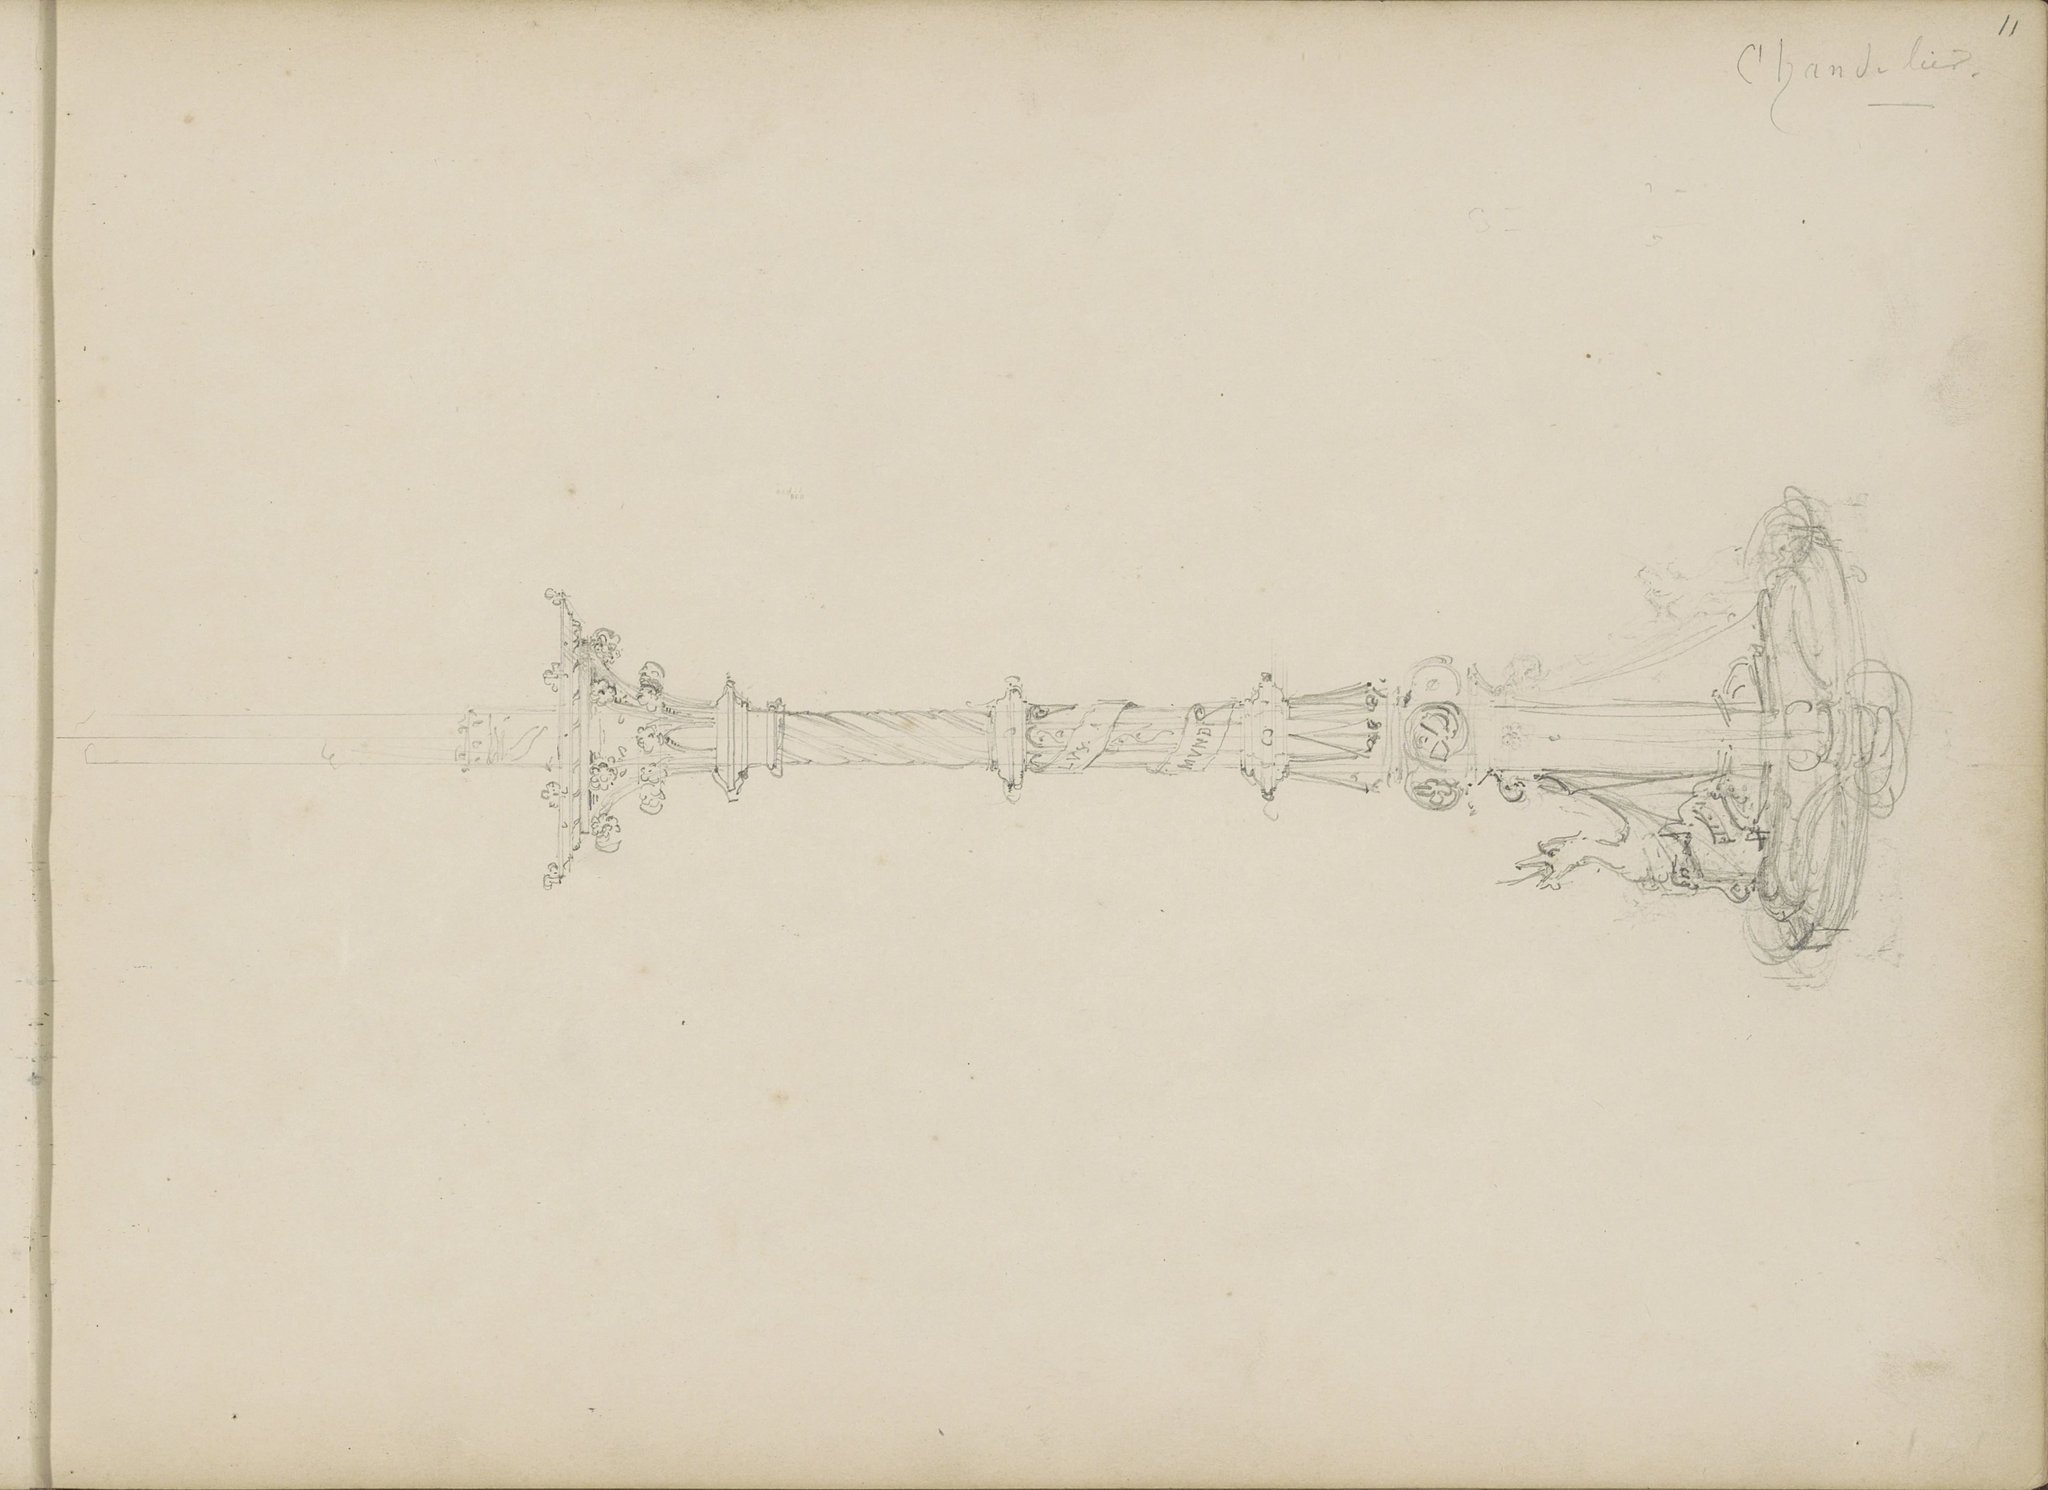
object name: sketchbook leaf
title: Kandelaar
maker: pierre joseph hubert cuypers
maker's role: draughtsman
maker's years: 1827-1921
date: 1857-1859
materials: paper, pencil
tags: candlestick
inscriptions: annotation: ‘chandelier.’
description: Blad 11 recto uit een schetsboek met 77 bladen.